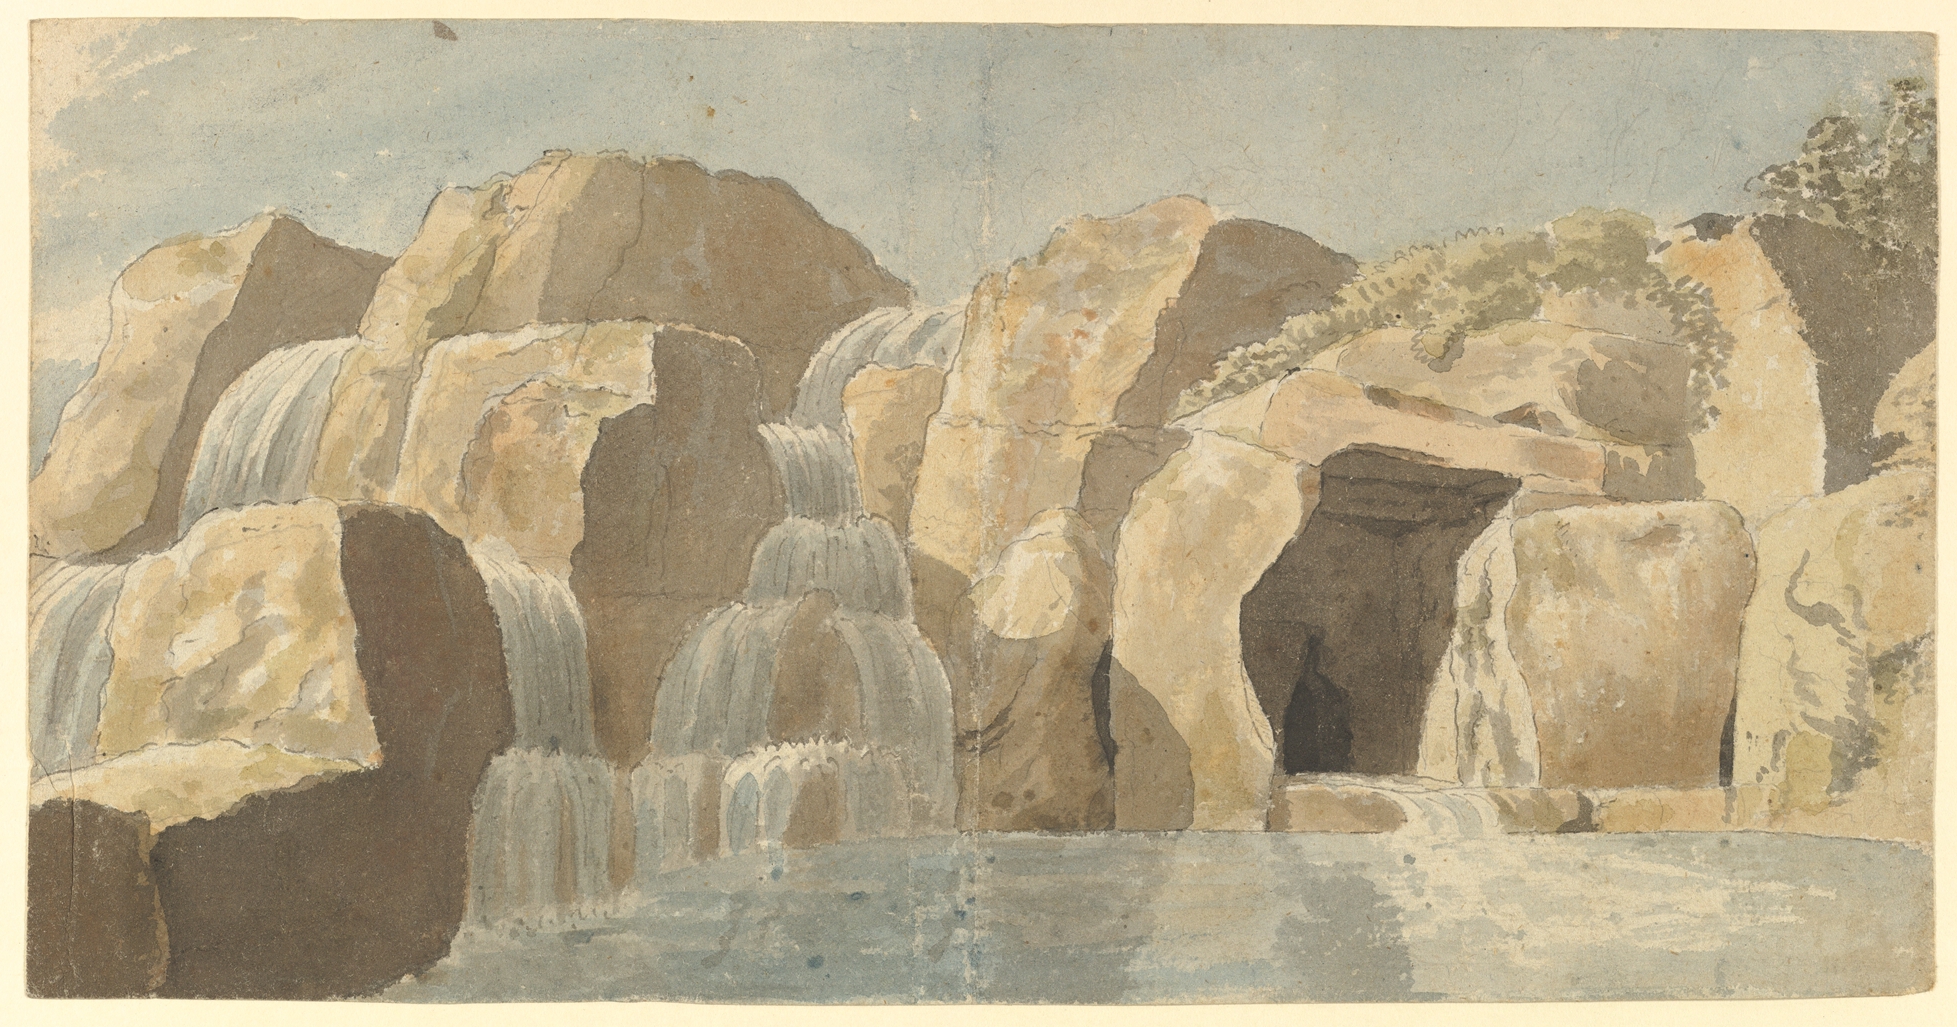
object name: drawing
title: Design for rock-work and cascades at Virginia Water, Windsor Great Park (recto). Rock-work Designs (verso)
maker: thomas sandby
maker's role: artist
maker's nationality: british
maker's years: 1723-1798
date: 1780-1789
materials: graphite, ink, watercolor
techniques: pen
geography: united kingdom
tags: parks,waterfalls